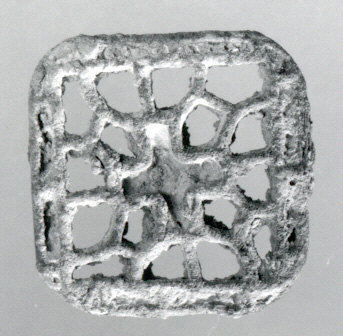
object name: stamp seal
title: Compartmented stamp seal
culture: bactria-margiana archaeological complex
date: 2333-1668 BCE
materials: copper alloy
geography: bactria-margiana